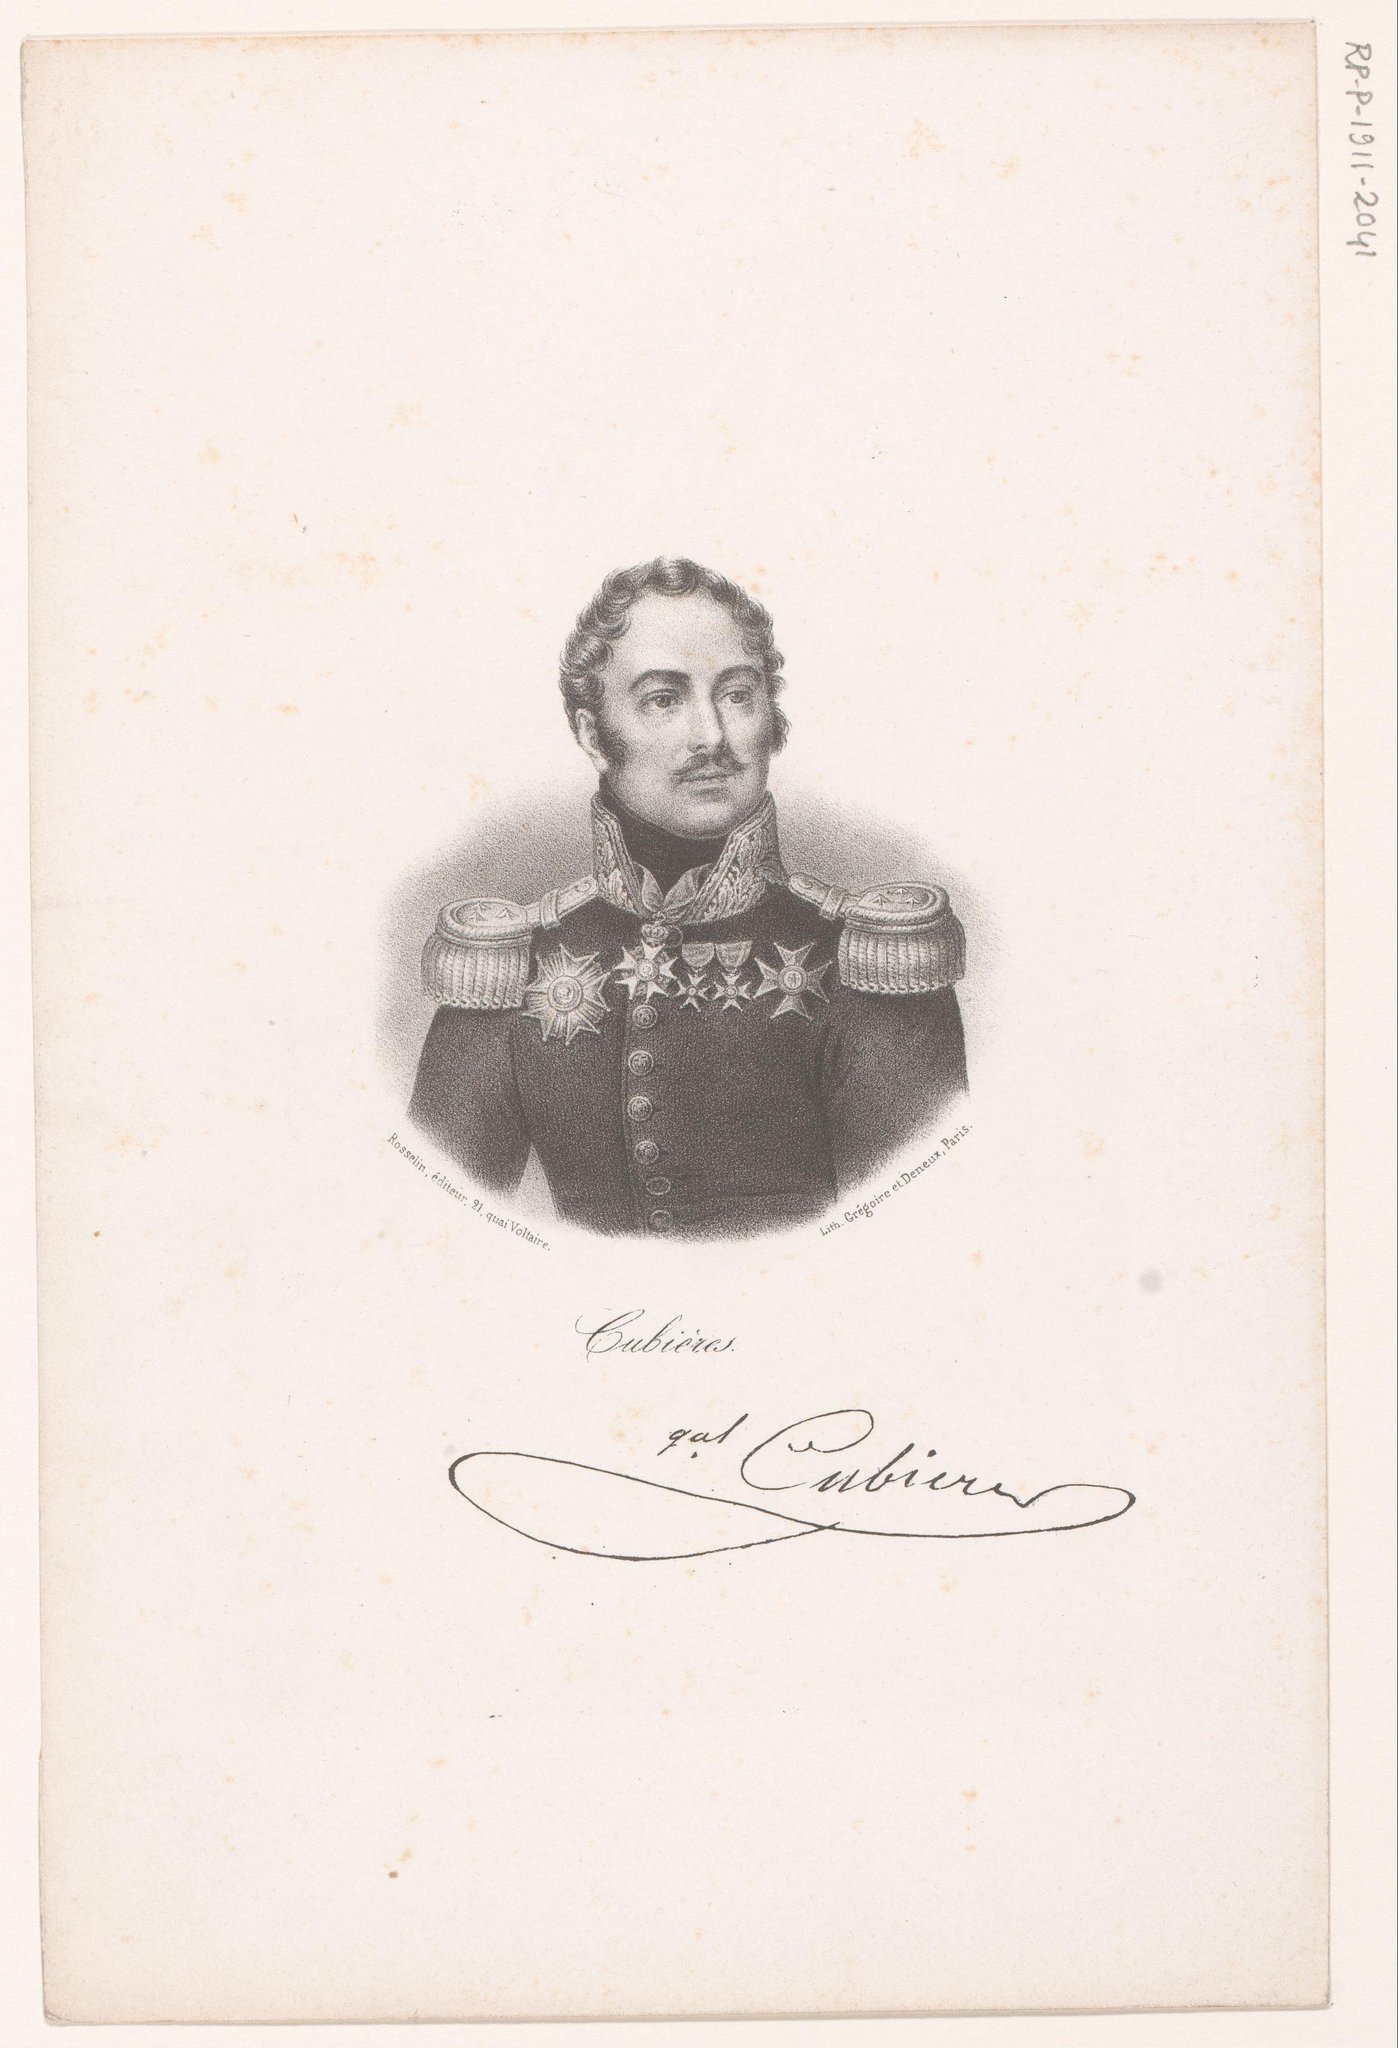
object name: print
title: Portret van Amédée Despans-Cubières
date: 1844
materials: paper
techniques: lithograph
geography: paris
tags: paris, politician, historical persons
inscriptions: collector's mark: Lugt 2228a